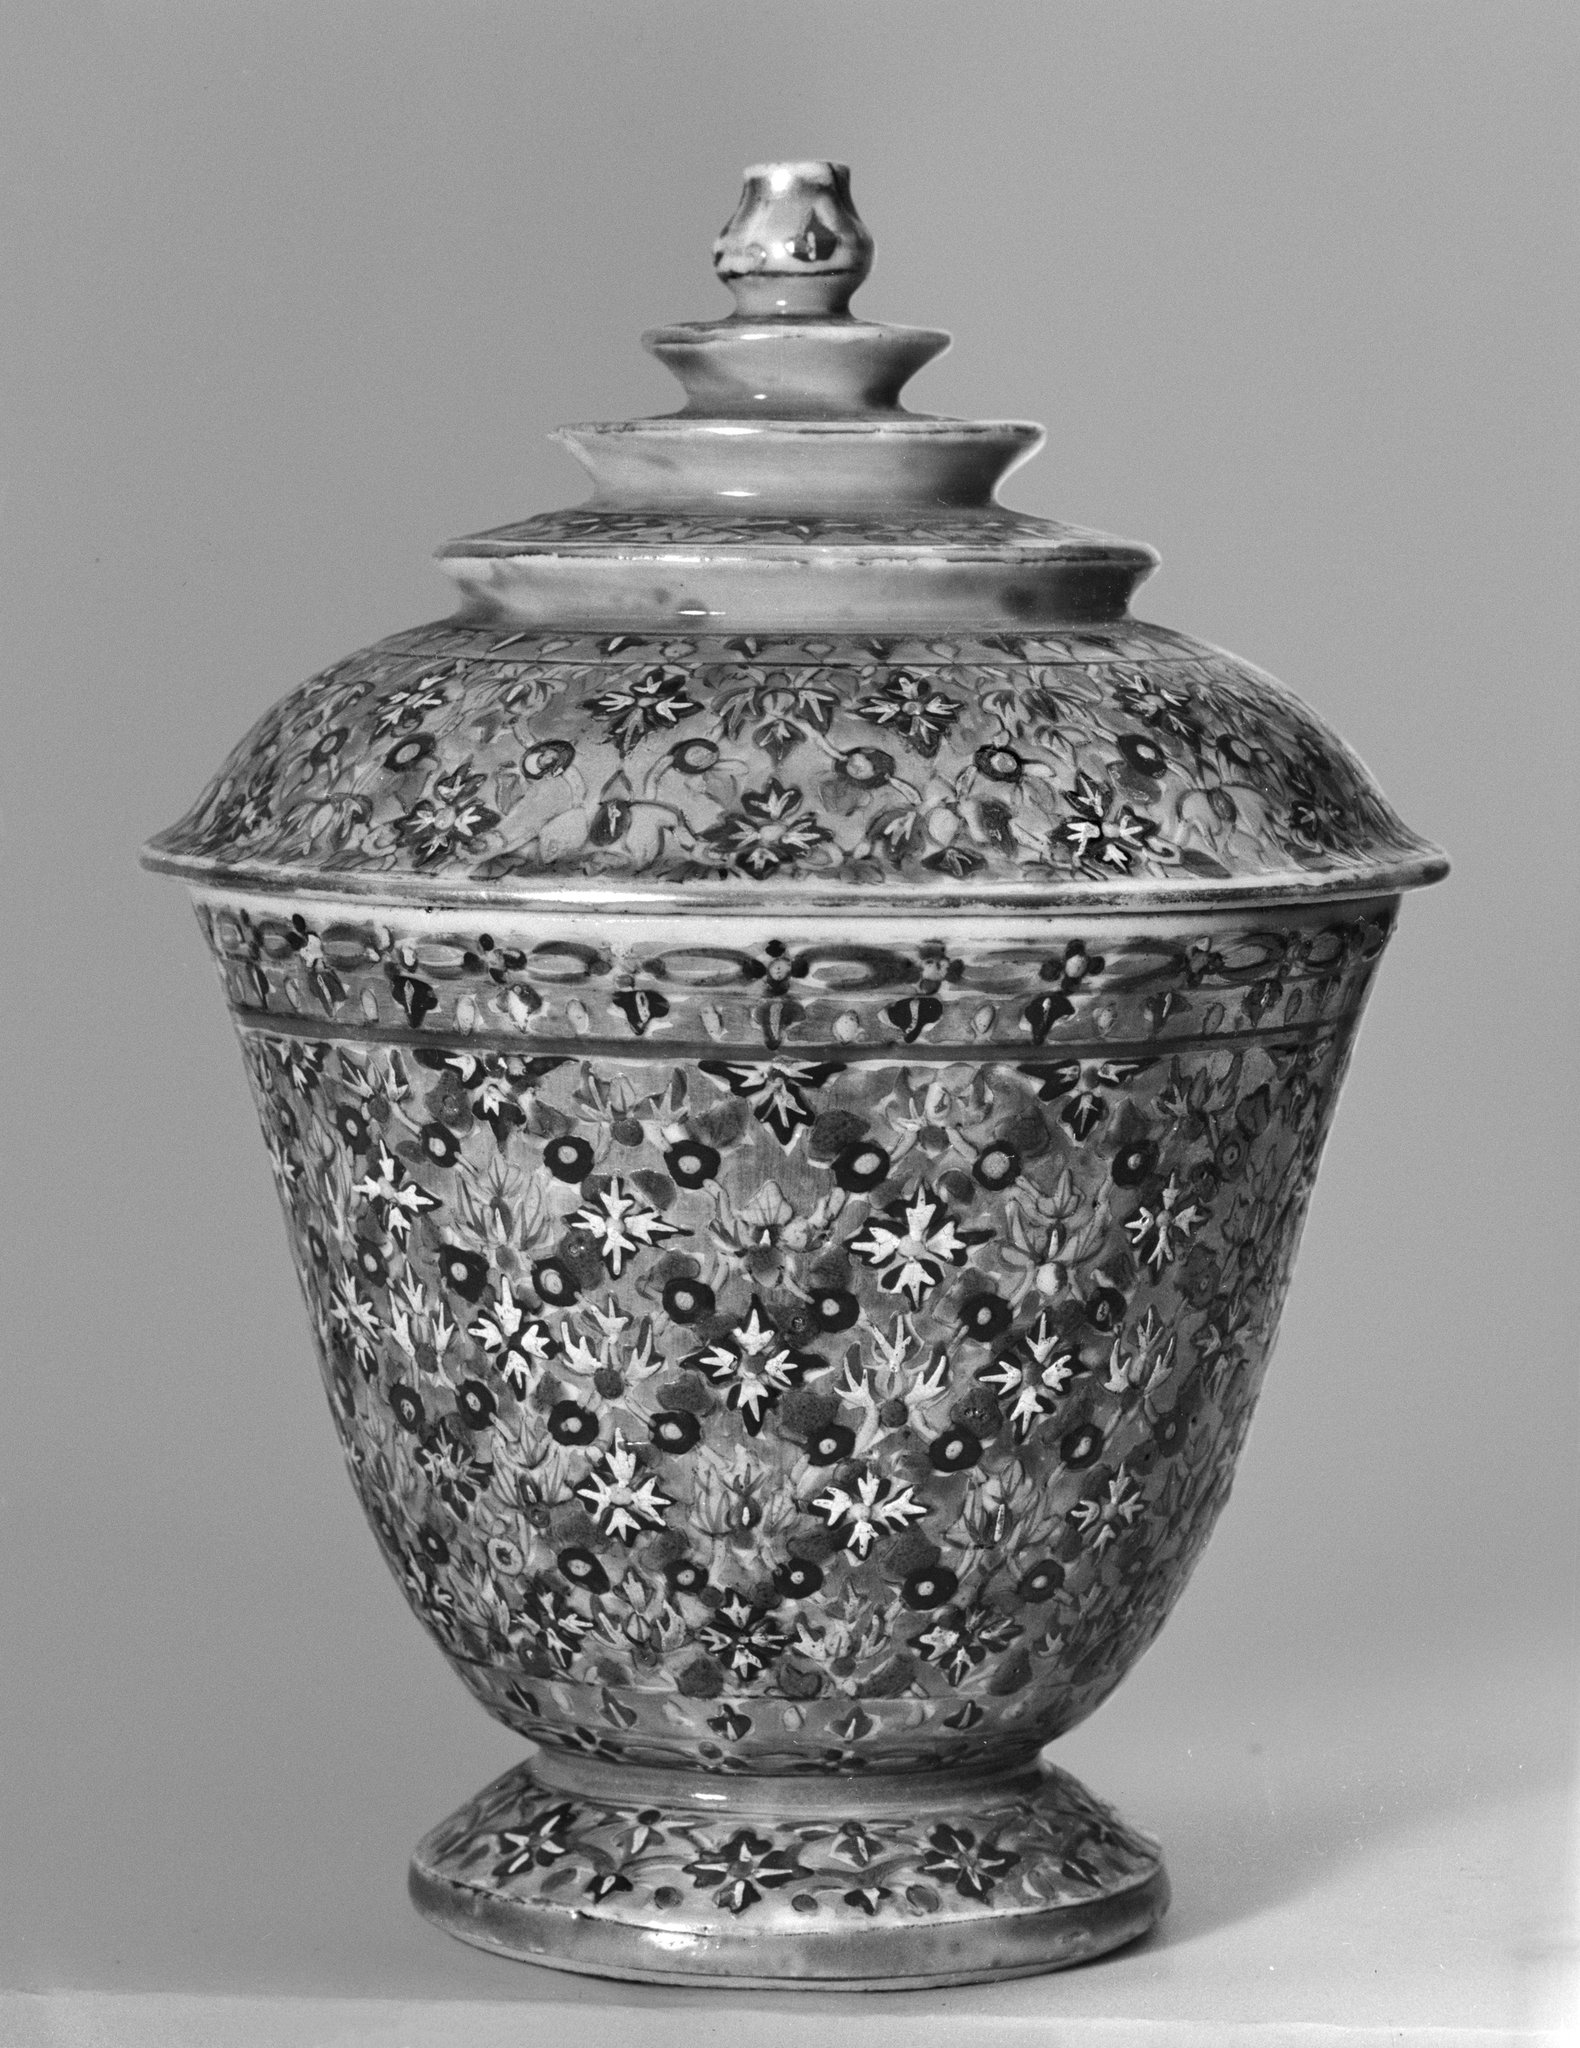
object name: covered cup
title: Covered cup with floral pattern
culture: chinese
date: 1801-1900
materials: enamel, porcelain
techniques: overglaze, painting, polychrome